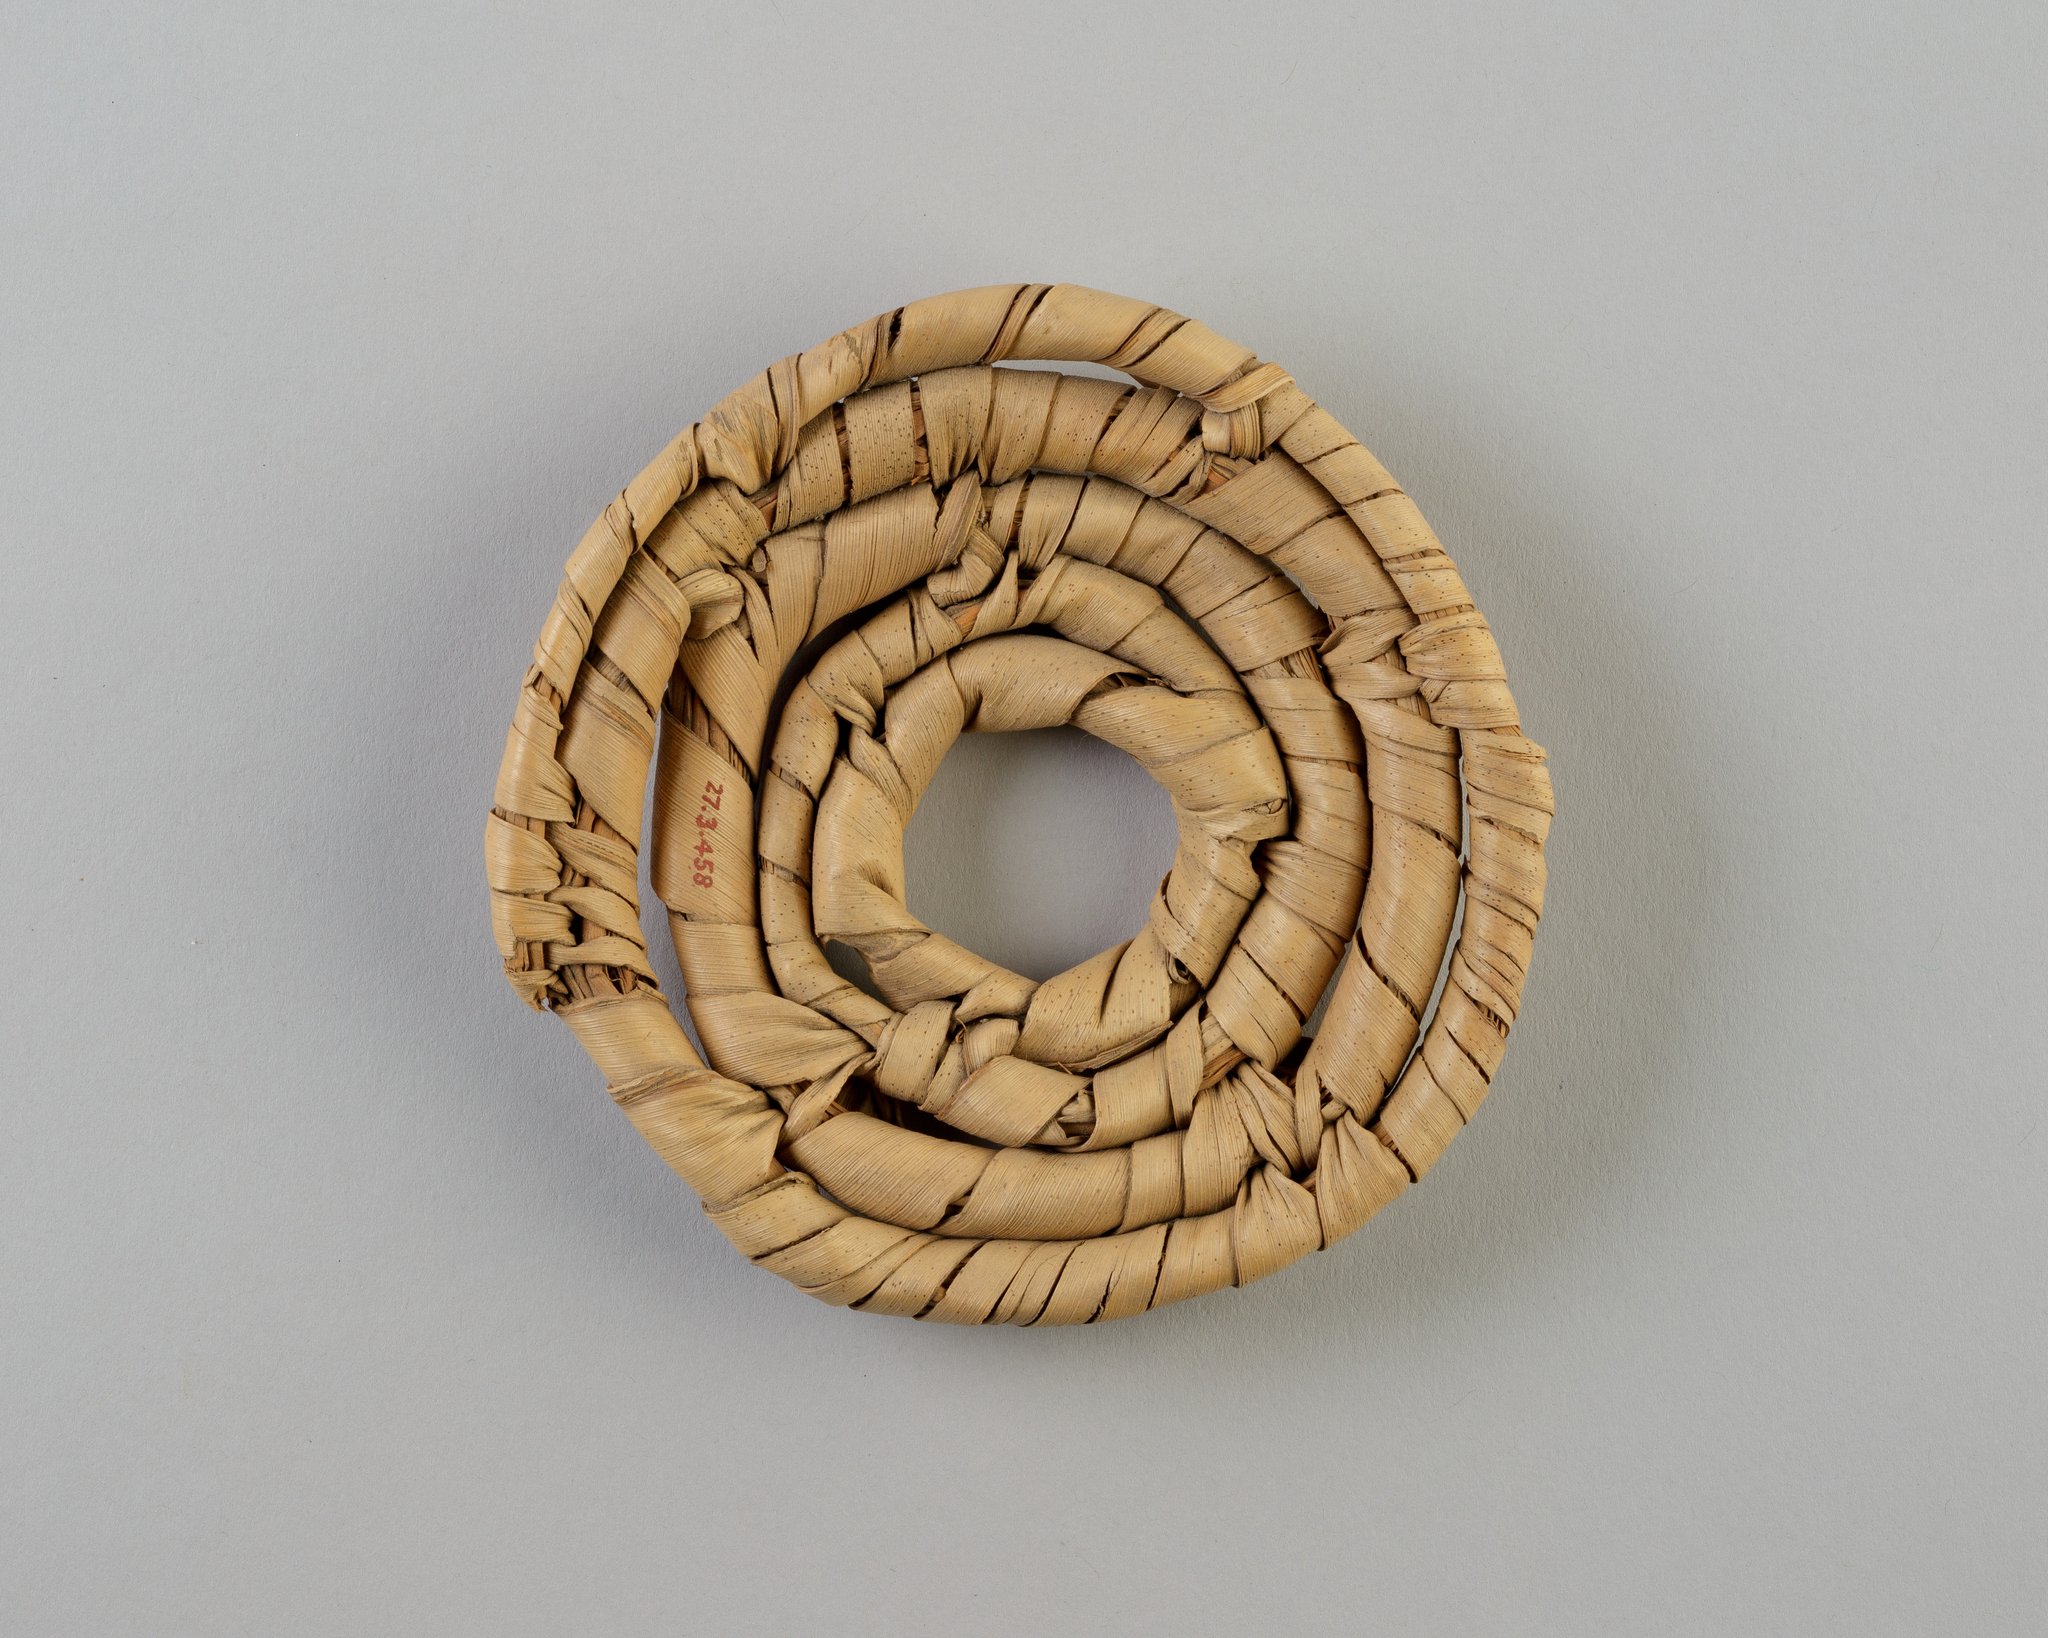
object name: basketry, model, senenmut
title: Pot Stand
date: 1479-1458 BCE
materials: leaf, fiber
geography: egypt